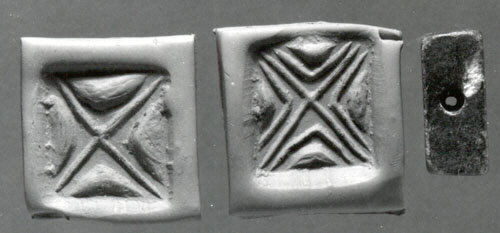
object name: stamp seal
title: Rectangular plaque seal, engraved on two faces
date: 3600-2900 BCE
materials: mineral, stone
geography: mesopotamia or syria or anatolia (?)